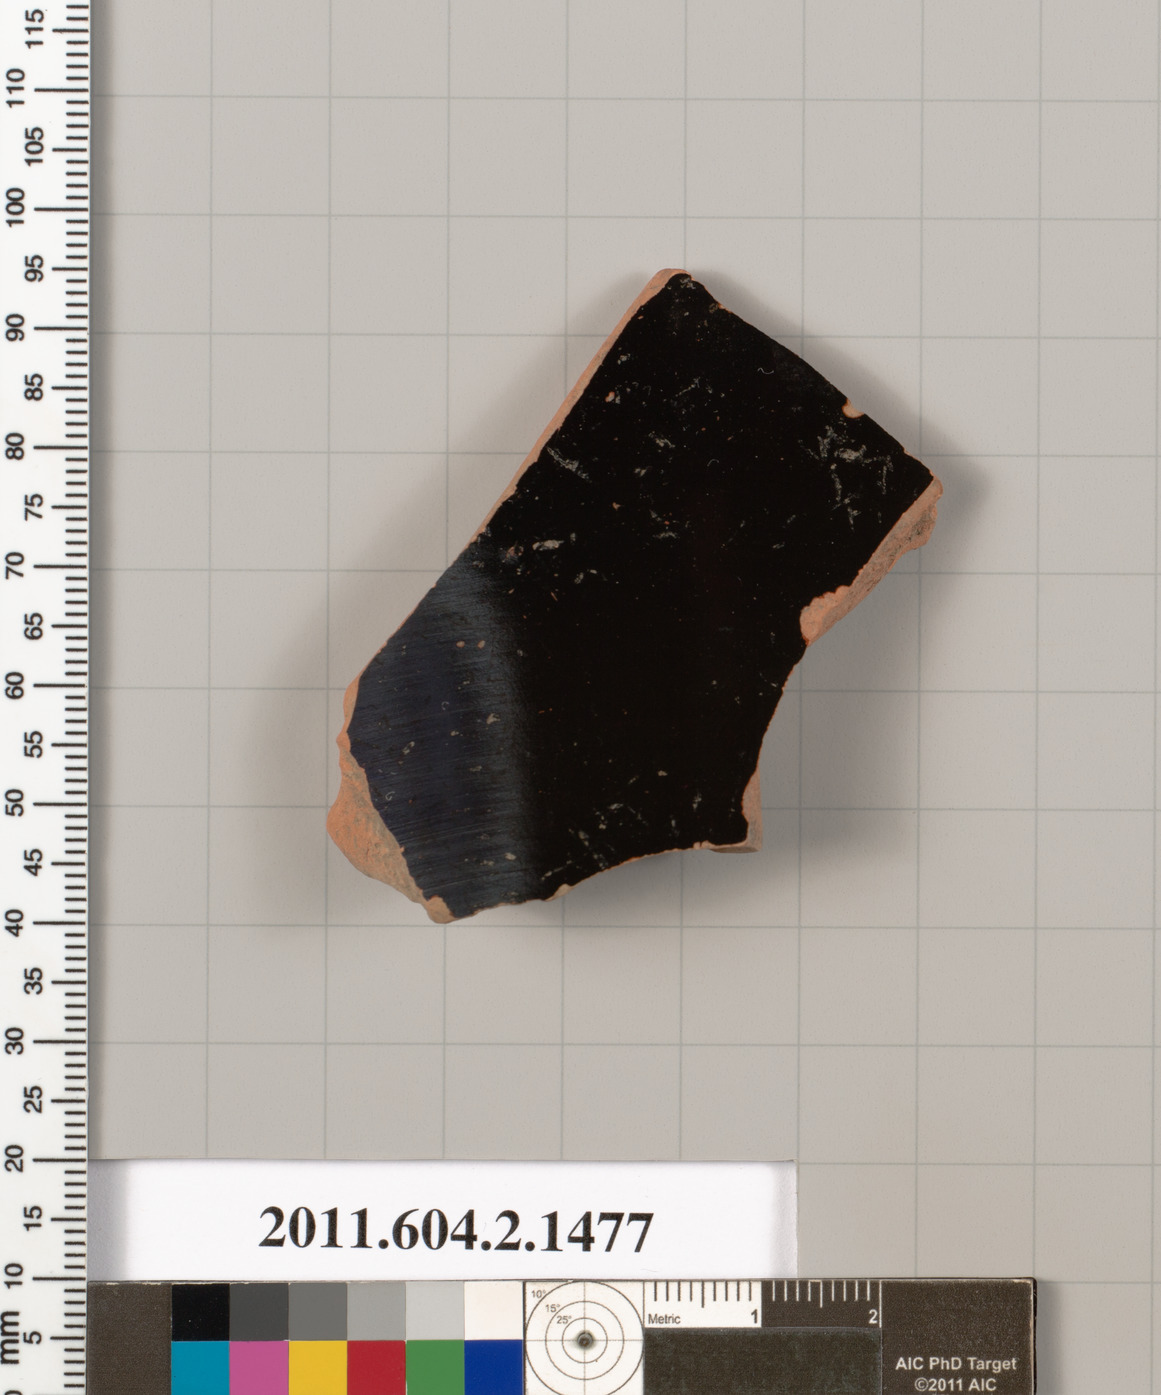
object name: skyphos fragment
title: Terracotta fragment of a skyphos (deep drinking cup)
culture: greek, attic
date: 600-401 BCE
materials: terracotta